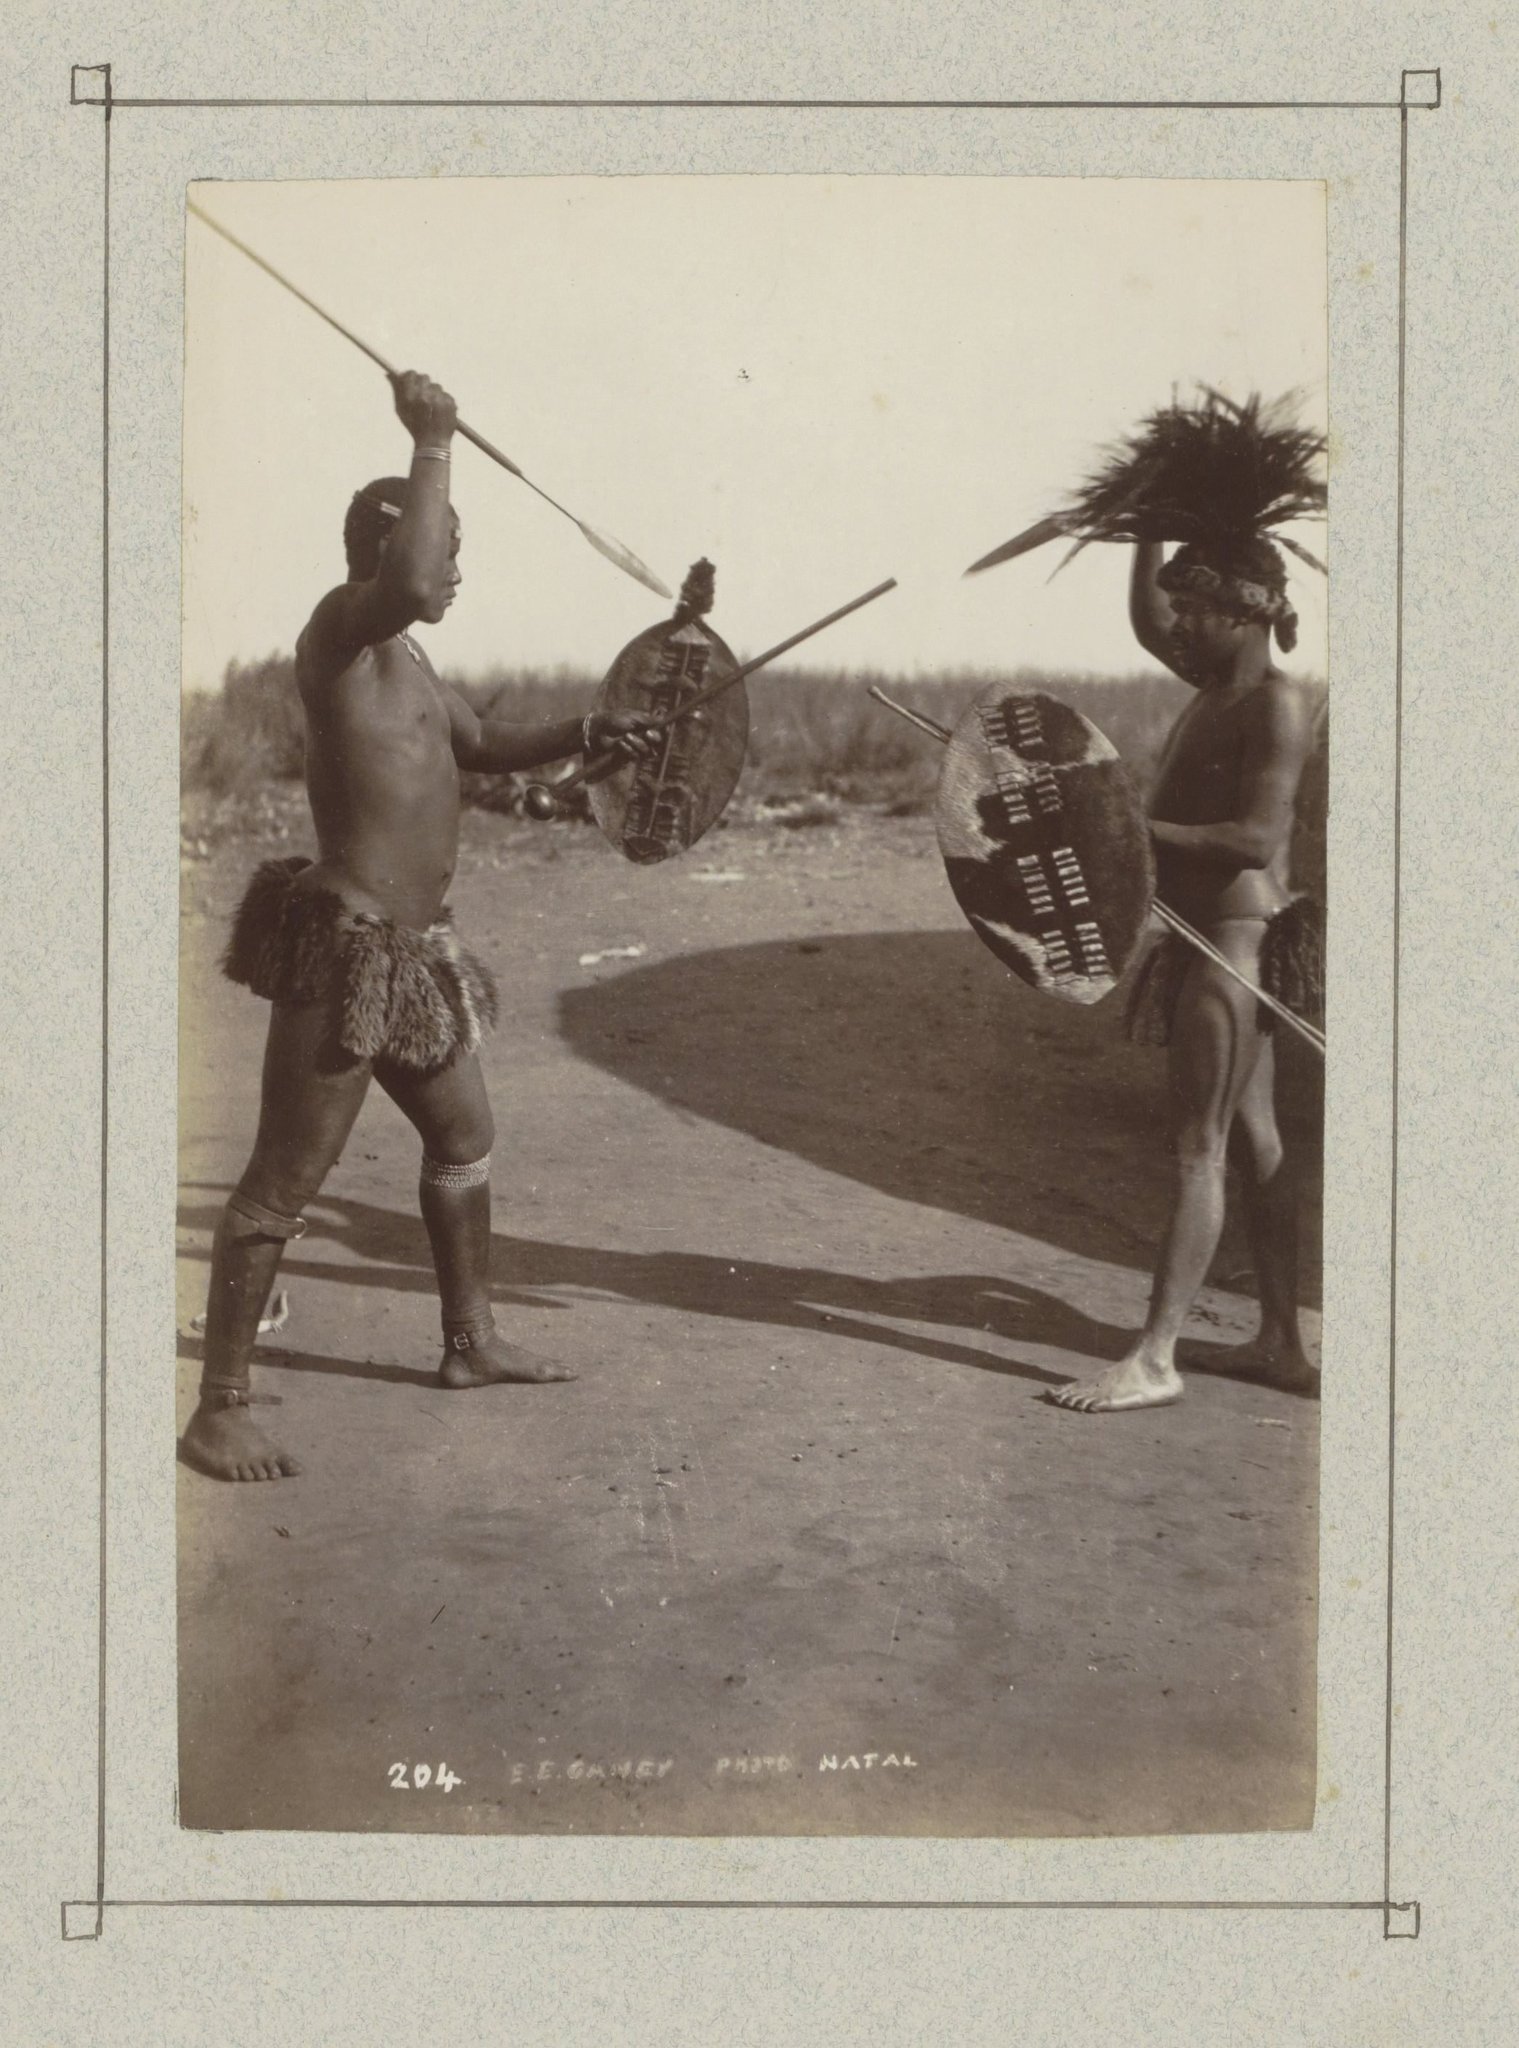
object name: photograph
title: Krijgers met speren in Natal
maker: ebenezer edmund caney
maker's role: fotograaf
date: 1880-1900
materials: photographic support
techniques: albumen print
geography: natal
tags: casting weapons: spear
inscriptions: number: ‘204’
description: Onderdeel van Reisalbum met foto's van Zuid-Afrika, Madeira, Portugal, Frankrijk en Duitsland.